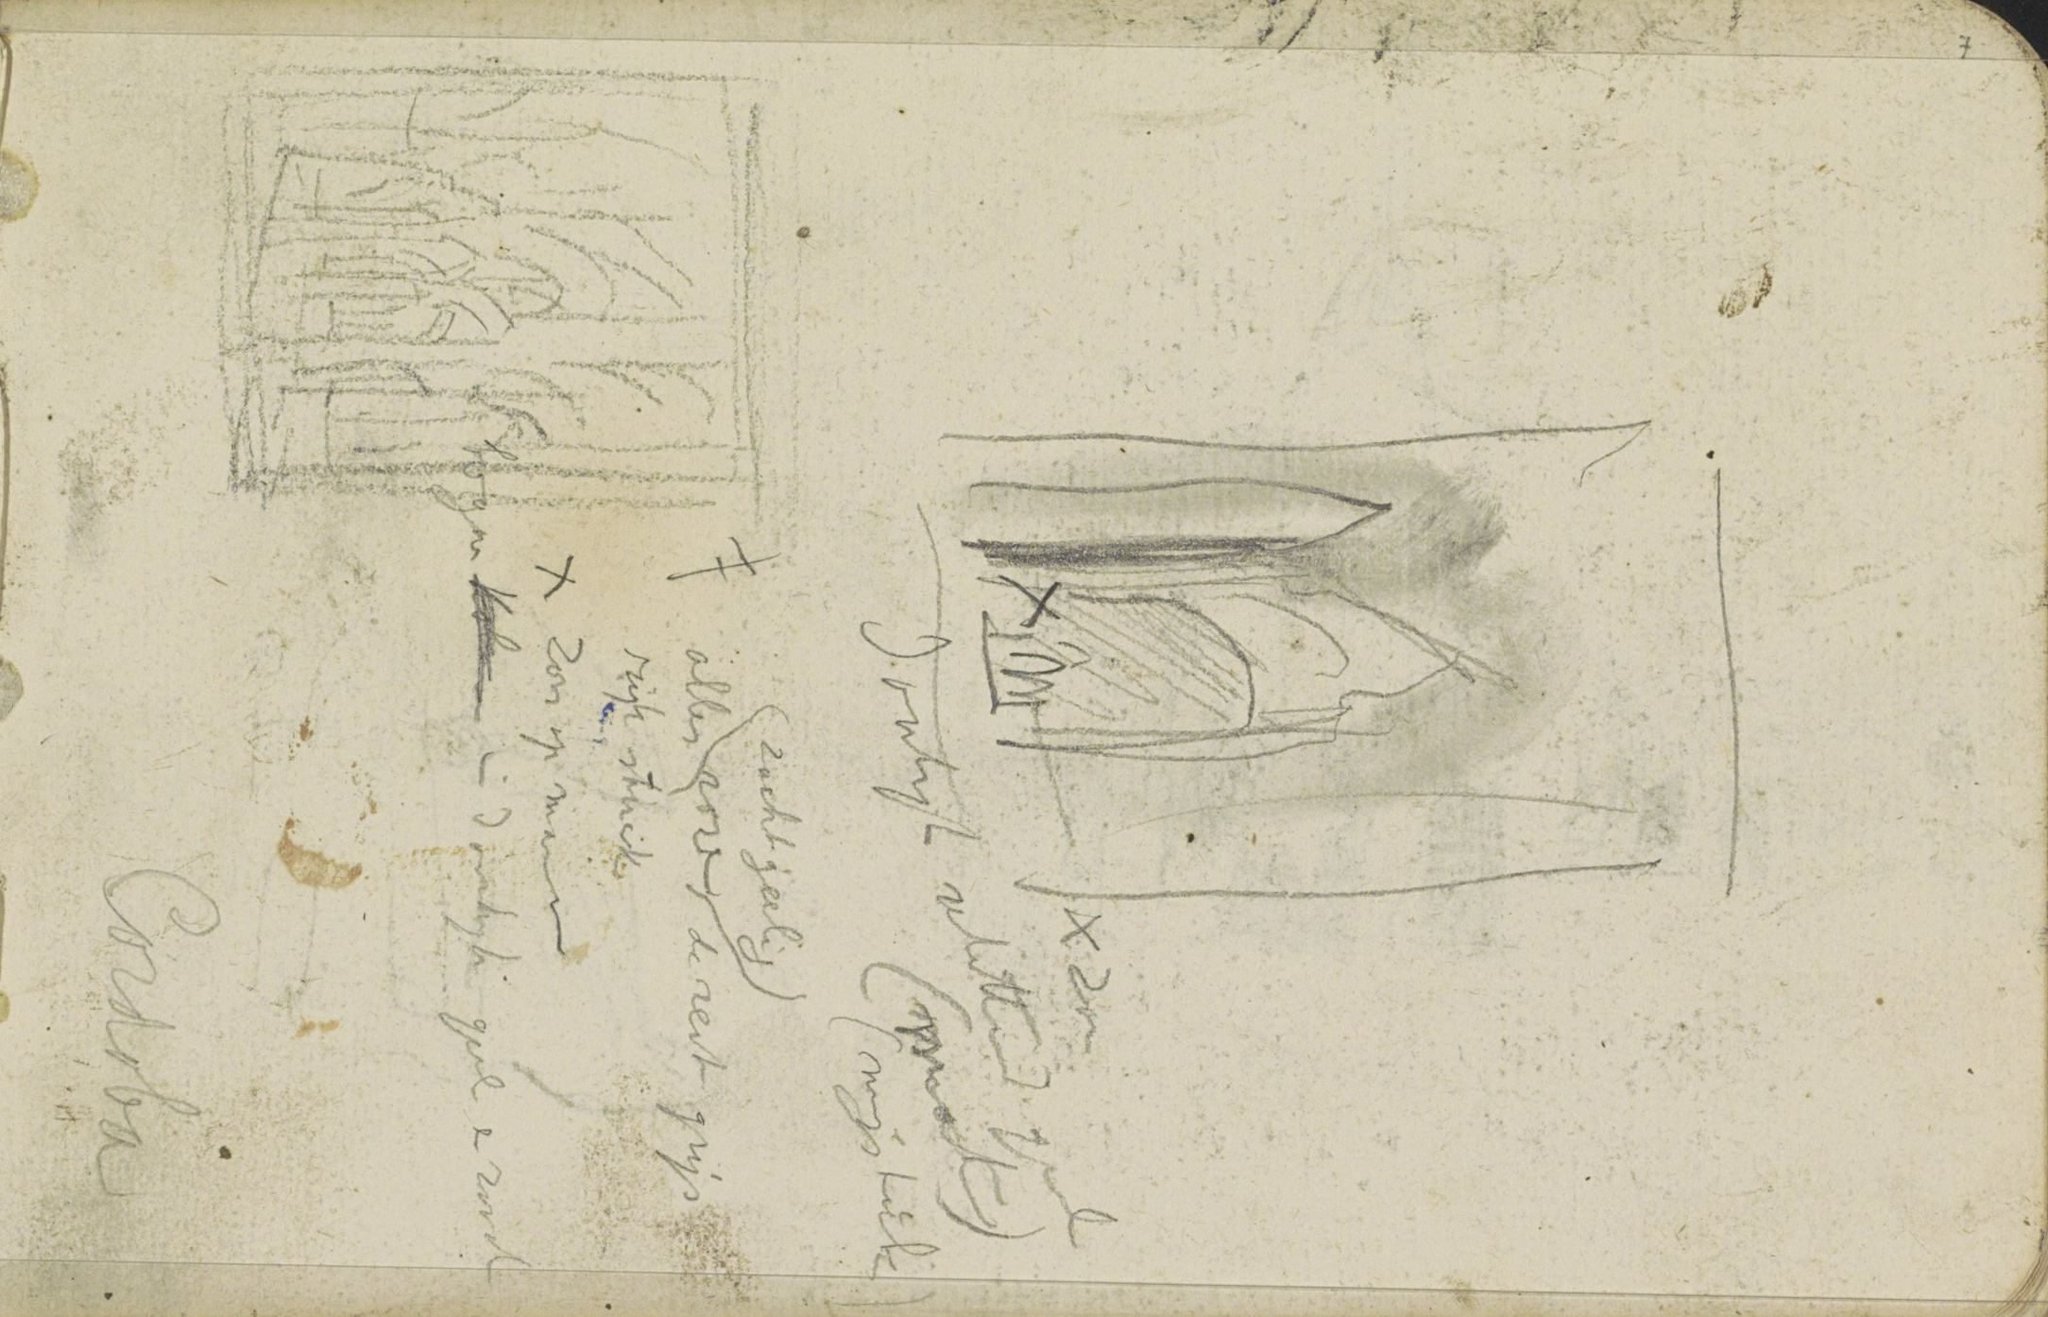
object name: sketchbook leaf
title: Interieur van de Mezquita kathedraal van Córdoba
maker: marius bauer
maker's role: draughtsman, print maker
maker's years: 1867-1932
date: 1902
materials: paper, pencil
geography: córdoba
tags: interior of church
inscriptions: annotation: ‘Cordoba’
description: Pagina 7 uit een schetsboek met 30 bladen.